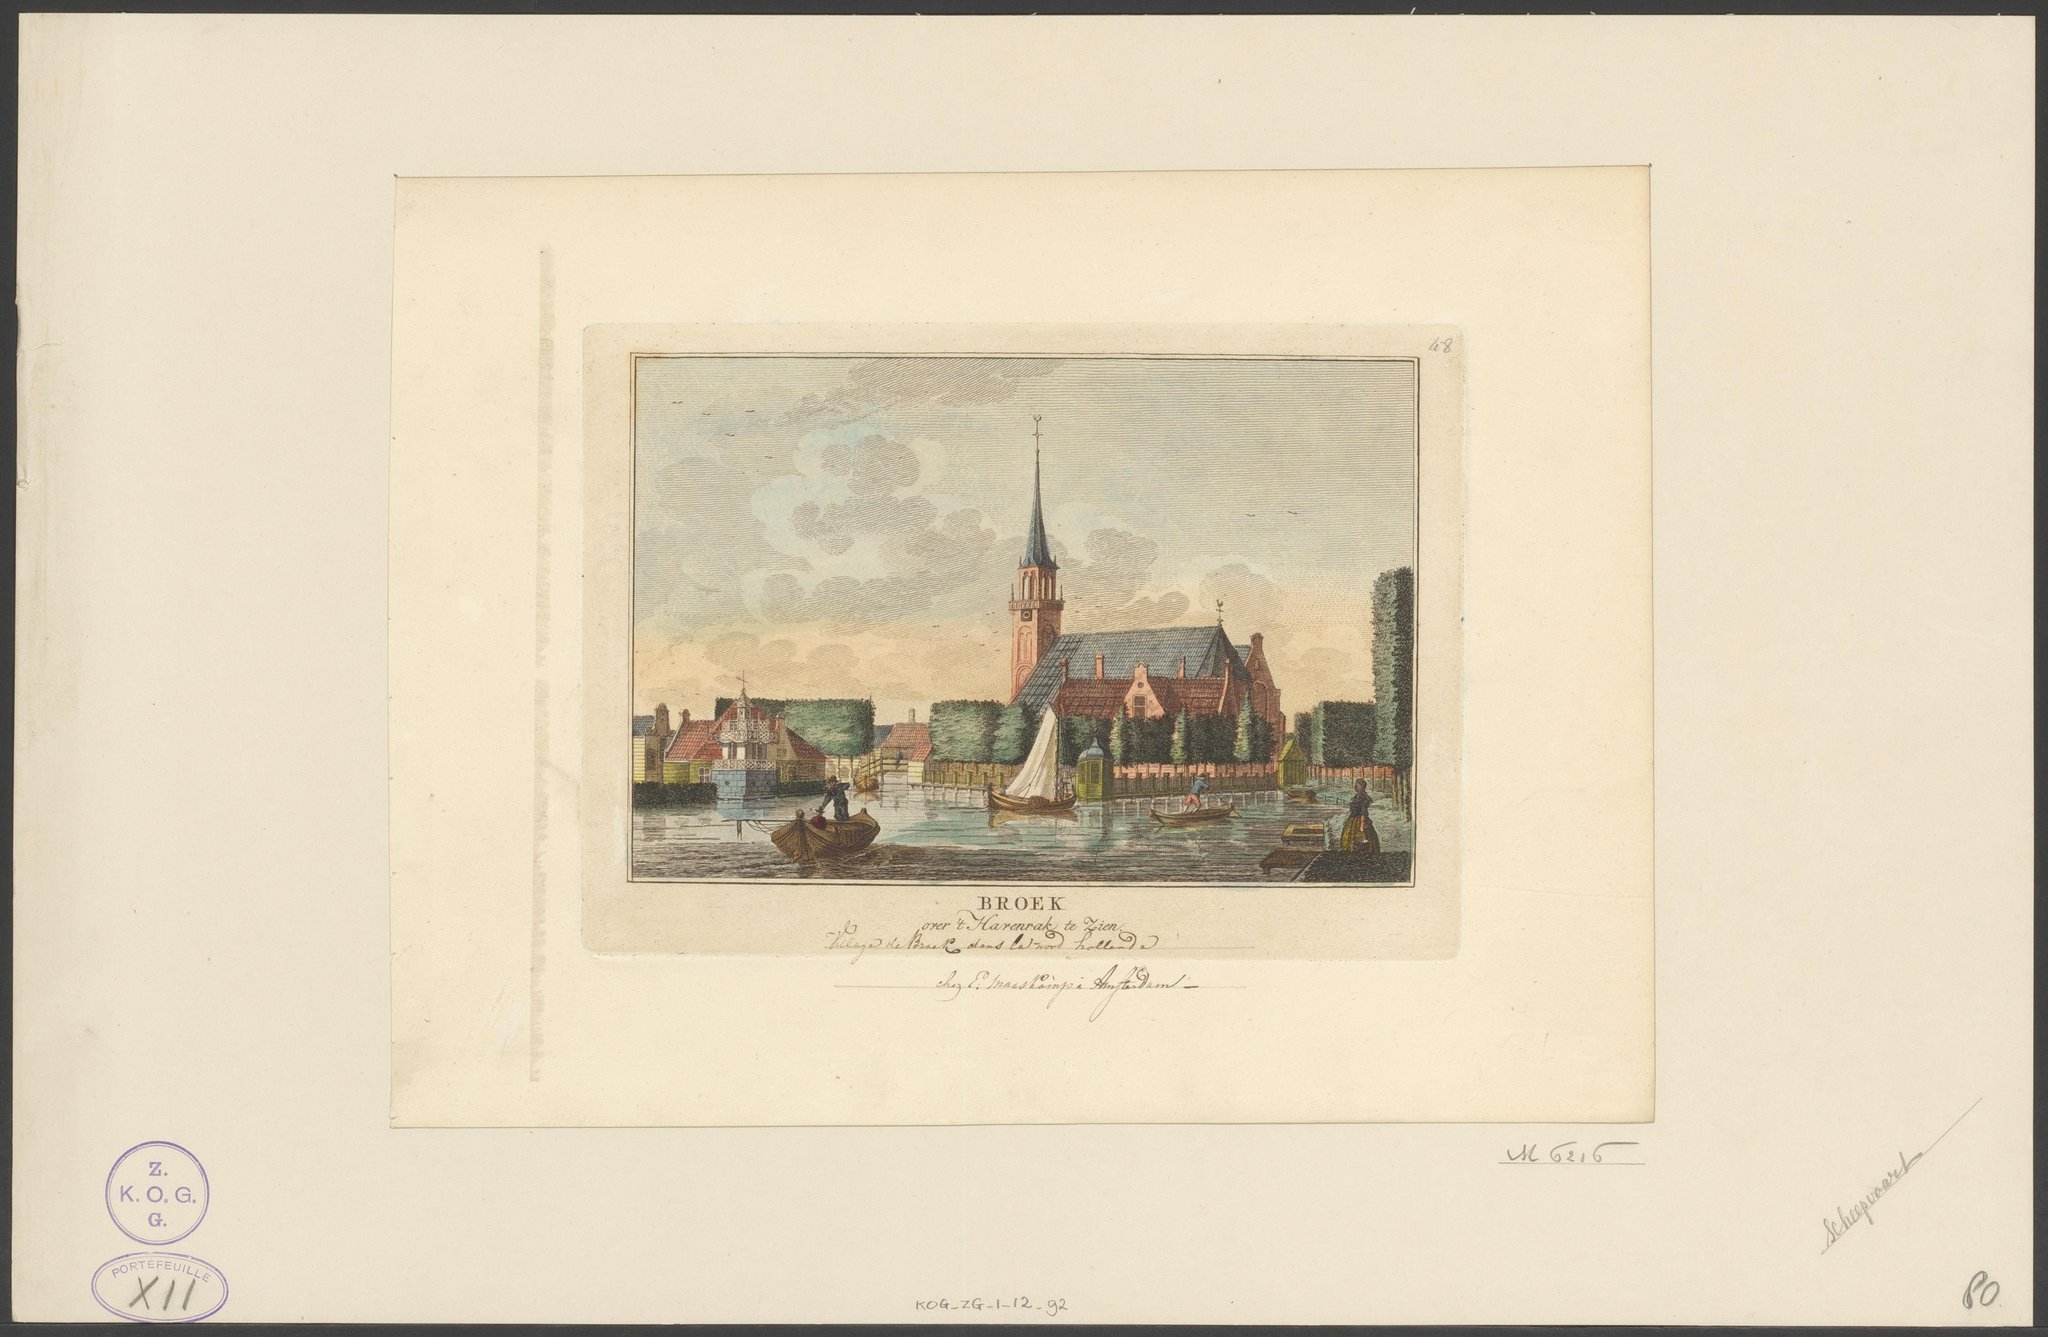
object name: print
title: Broek in Waterland, ca. 1790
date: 1824-1825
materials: paper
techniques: engraving, etching, hand coloring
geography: amsterdam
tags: city-view, and landscape with man-made constructions, canal, church (exterior)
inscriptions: collector's mark: Lugt 1641, stamp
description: Huidige staat van prent uitgegeven als onderdeel van een plaatwerk uit ca. 1824-1825 met 74 (ongenummerde) platen van de belangrijkste topografische gezichten en verschillende zeden en gewoonten in het Verenigd Koninkrijk der Nederlanden, getiteld 'Tableau des principales vues des palais et édifices : représentations et des coutumes et usages, dans les provinces septentrionales du Royaume des Pays-Bas'. Eerdere staat gebruikt in: Vaderlandsche gezichten, of afbeeldingen van den tegenwoordigen staat der Vereenigde Nederlanden (…). Amsterdam: Hendrik Gartman, Willem Vermandel en Jan Willem Smit, 1786-1792. Uitgegeven in afleveringen met ieder een eigen bifolium en inhoudsopgave. Alle prenten in deze publicatie zijn gegraveerd door Carel Frederik Bendorp (I) en, in de meeste gevallen, gebaseerd op tekeningen van Jan Bulthuis.